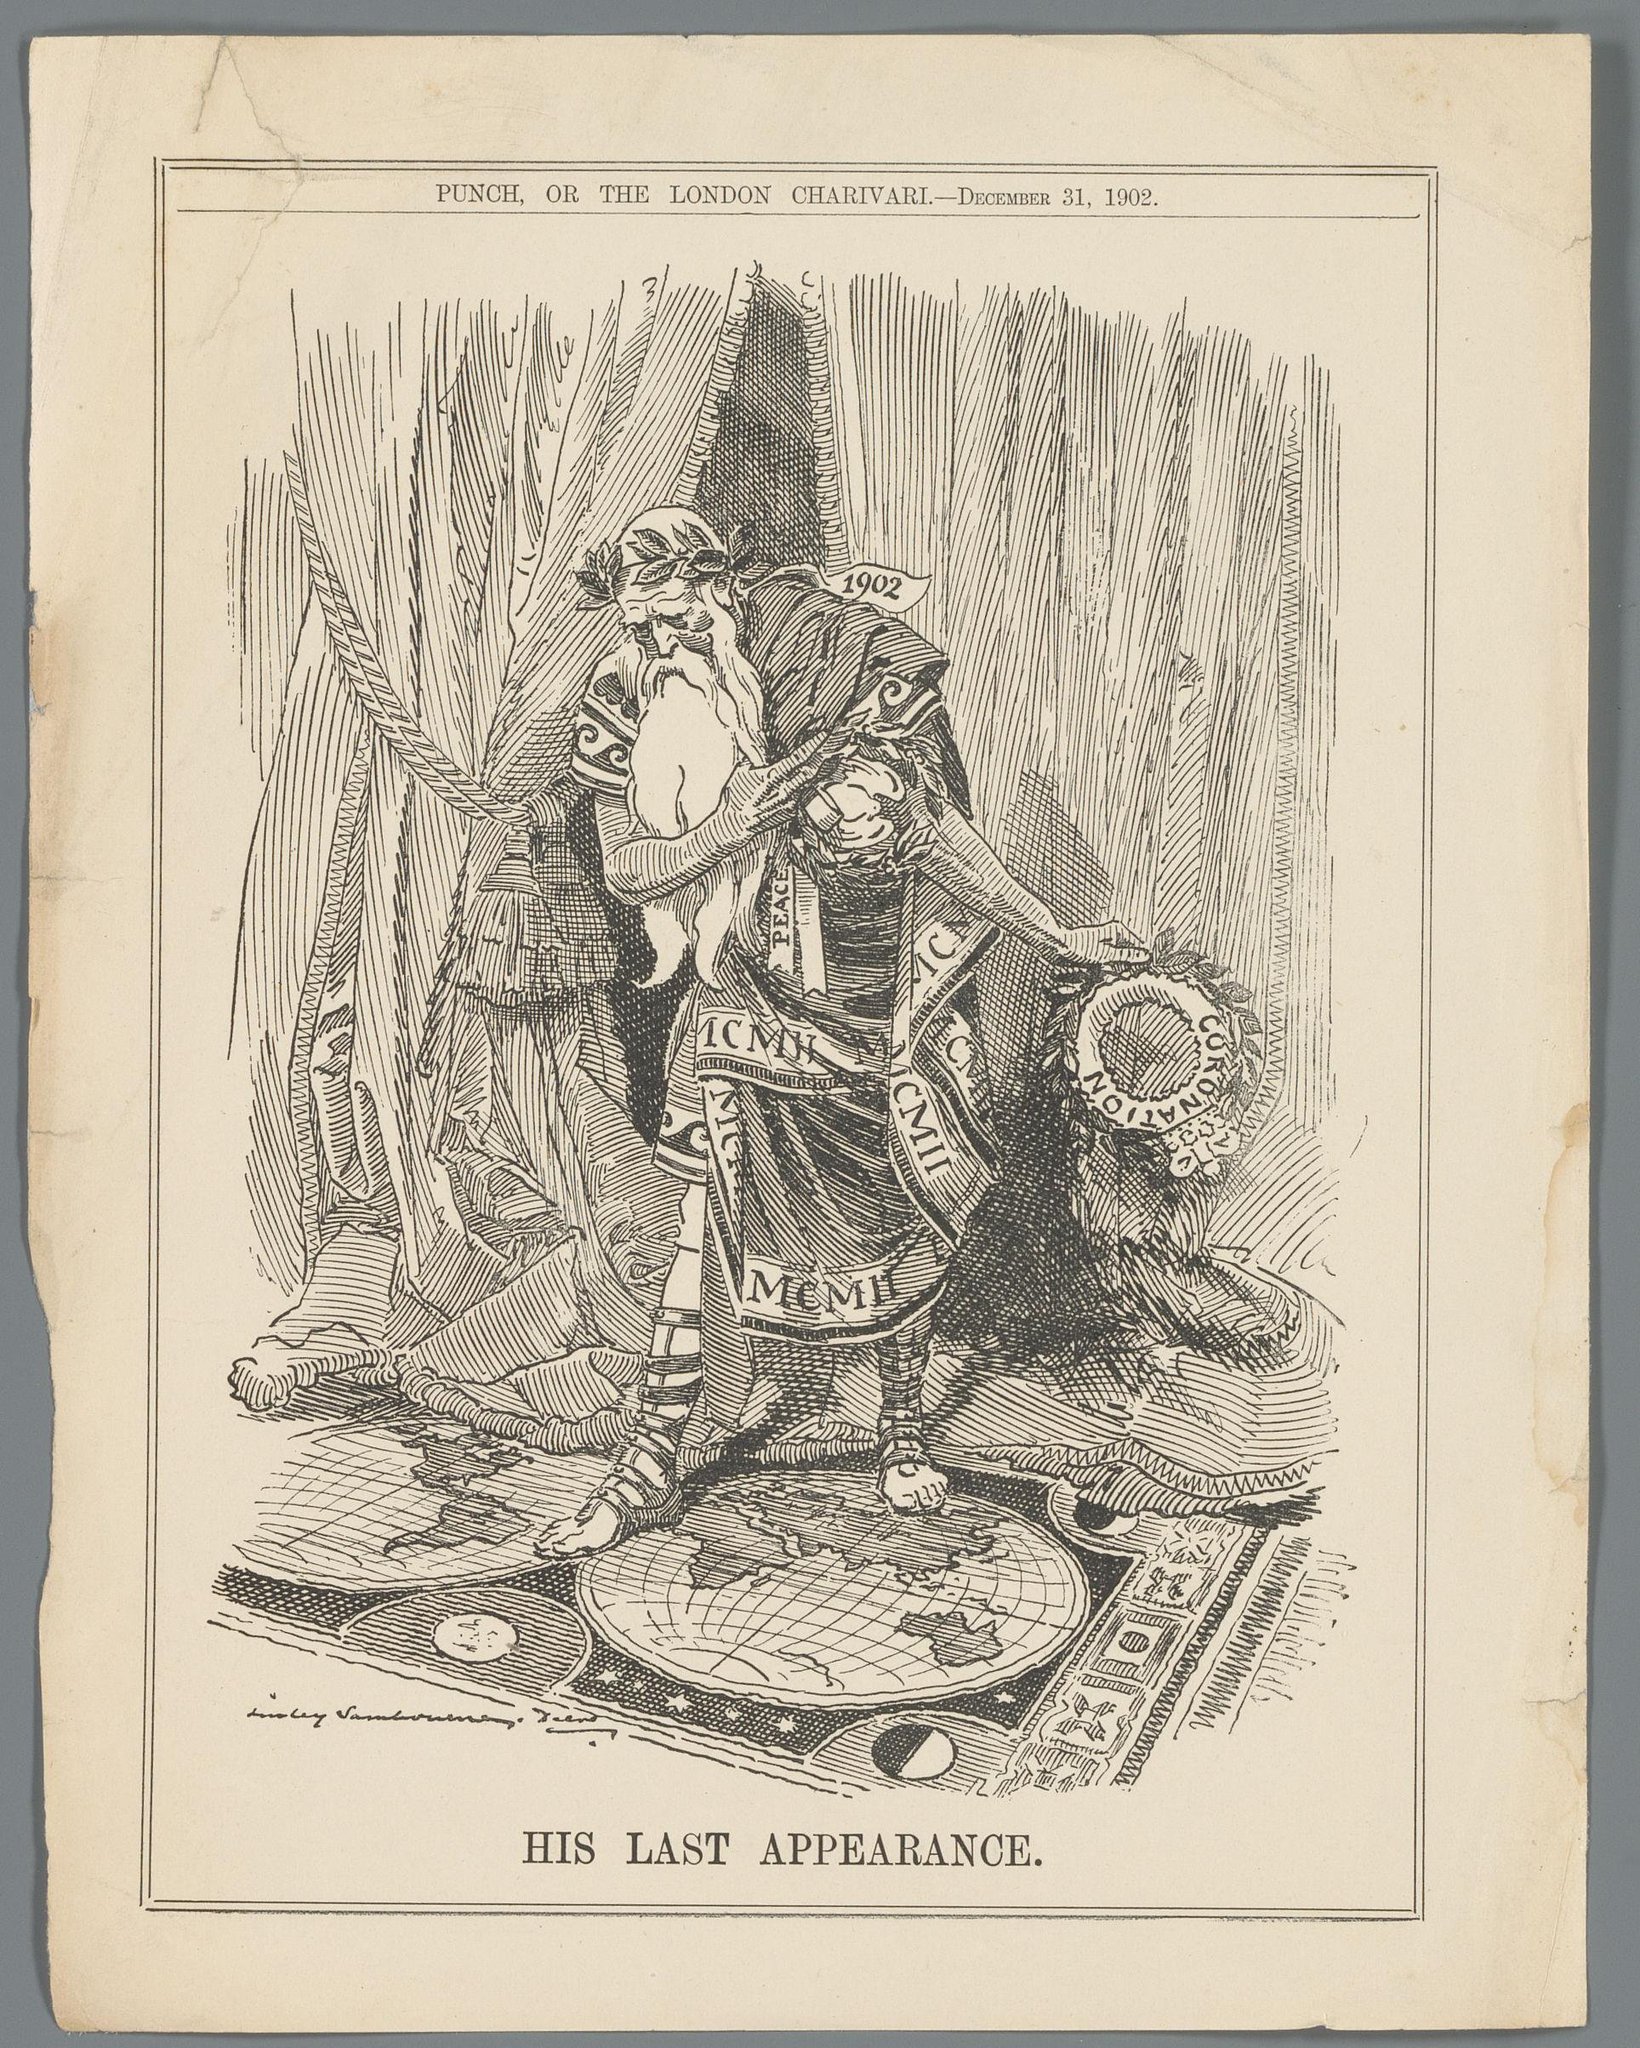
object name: print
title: Afscheid van 1902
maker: edward linley sambourne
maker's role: draughtsman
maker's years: 1844-1910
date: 1902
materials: paper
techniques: line block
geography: england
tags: annus, personification of the year, actor (on the stage), political caricatures and satires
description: Afscheid van het jaar 1902, voorgesteld als een oude man die op het toneel een buiging maakt en zijn publiek bedankt. In zijn hand houdt hij een krans verwijzend naar de kroning van Edward VII tot koning op 9 augustus 1902. Spotprent uit het Engelse satirische tijdschrift Punch, 31 december 1902.